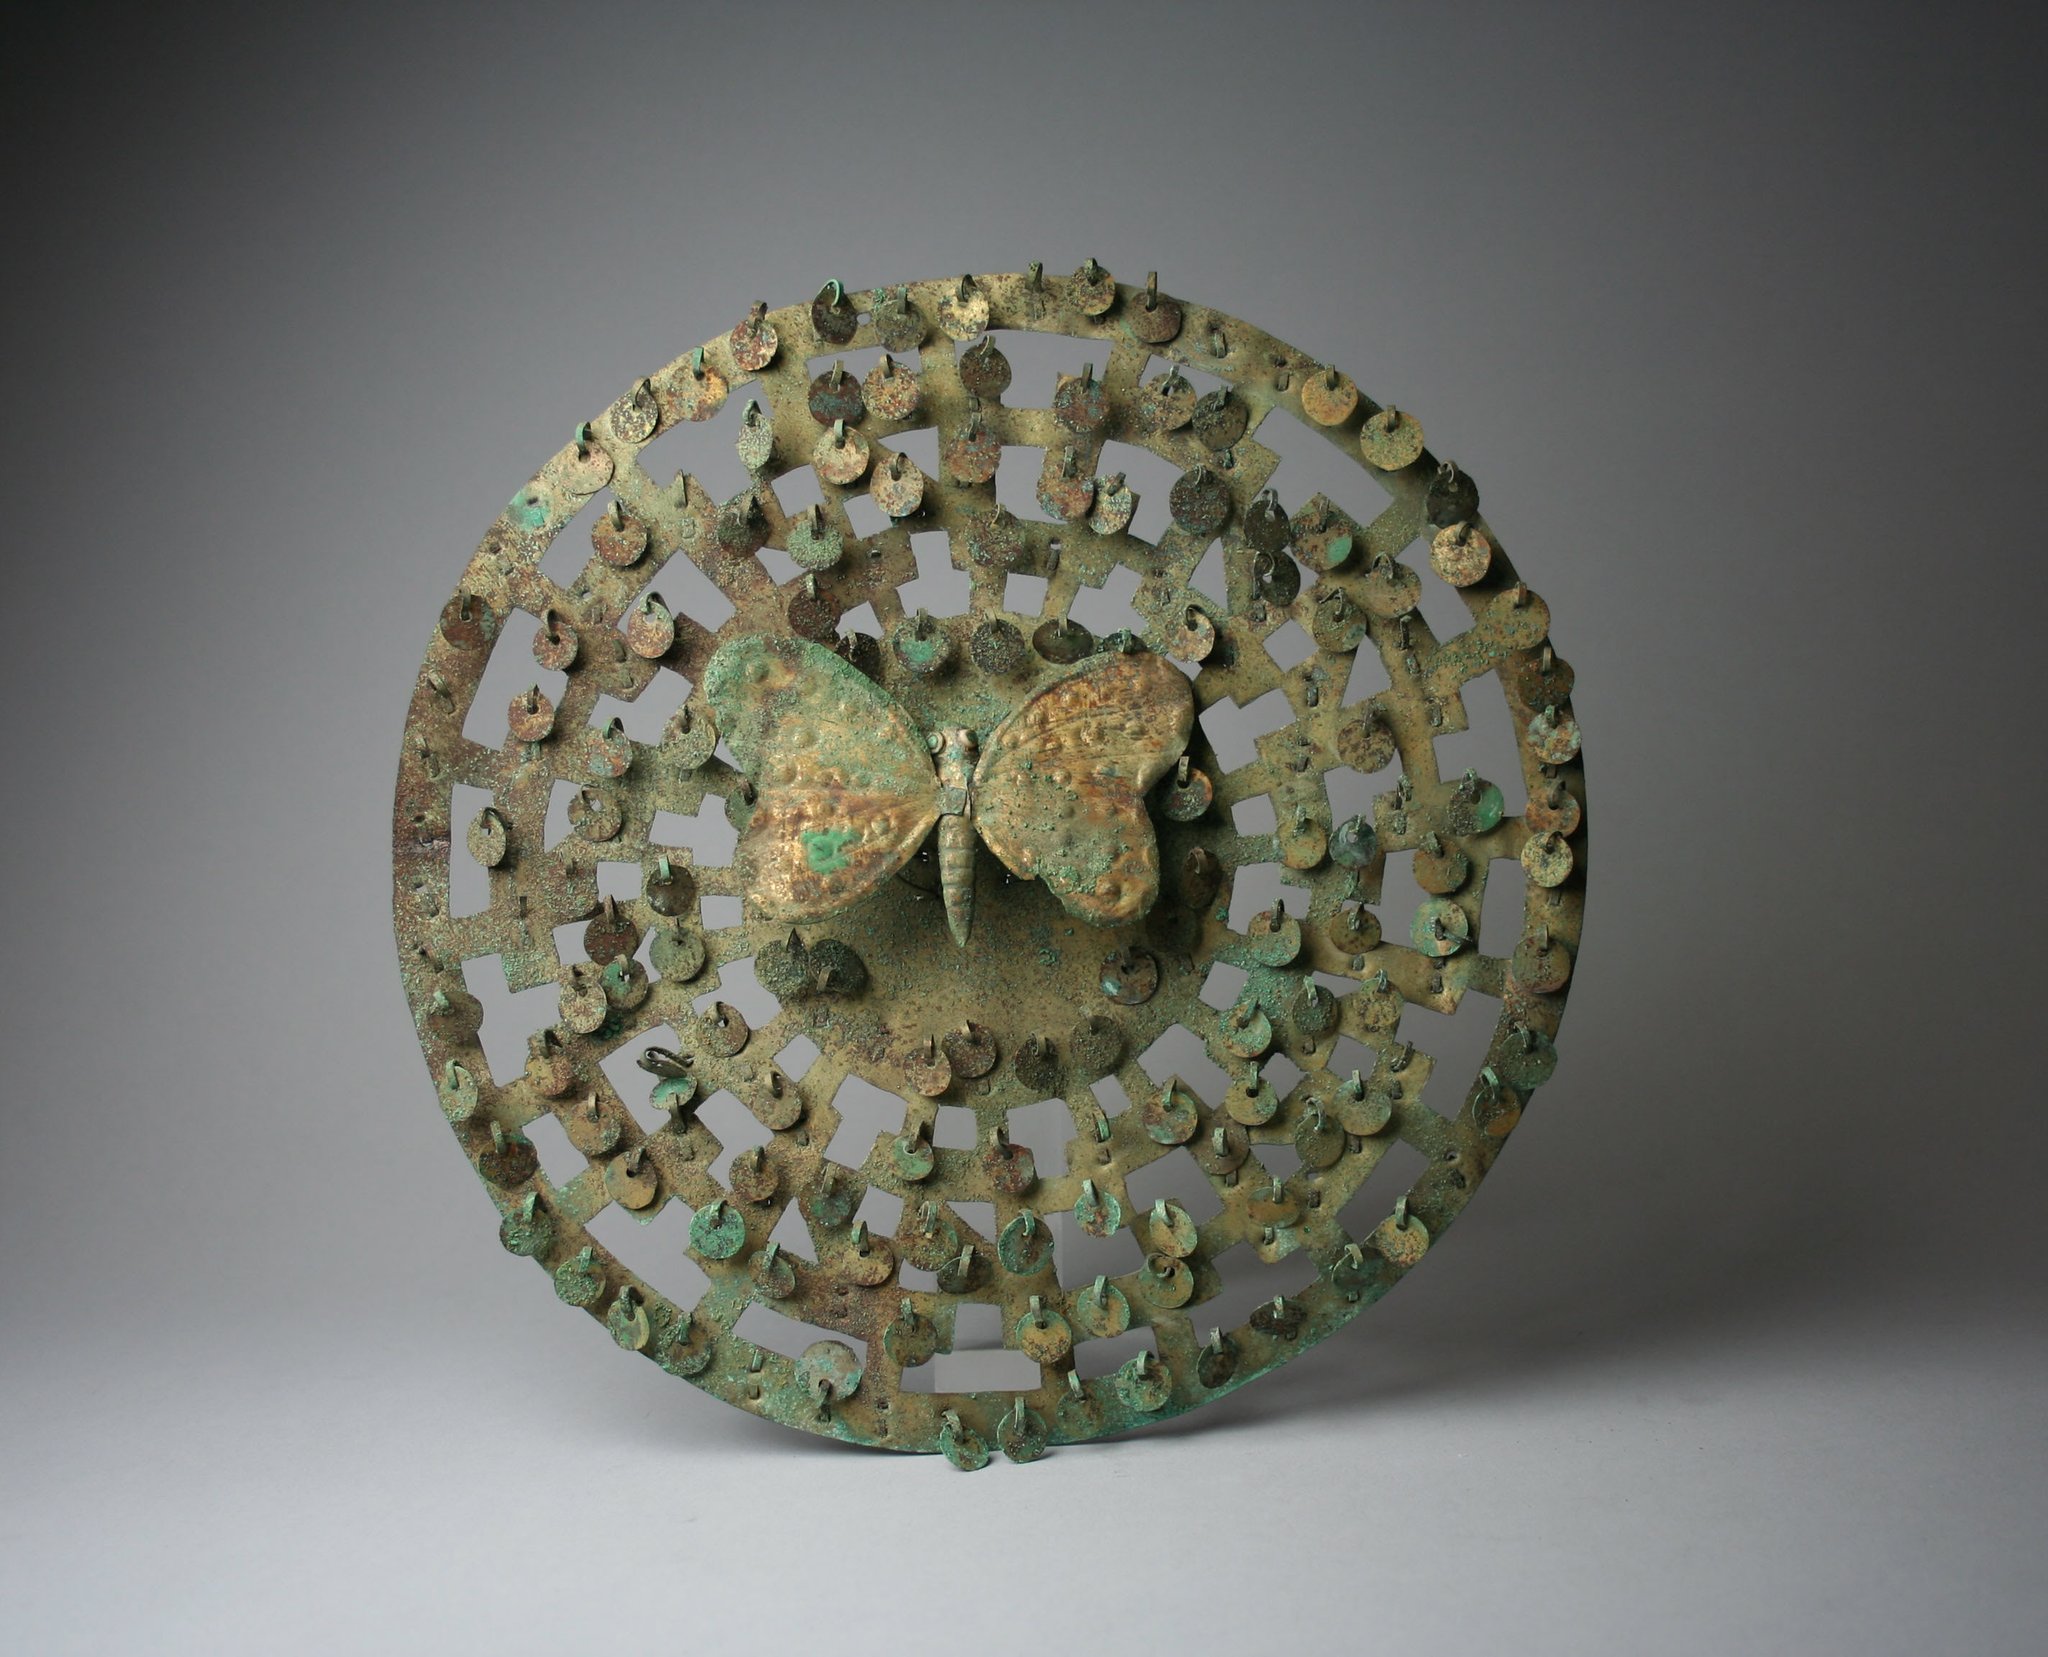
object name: ornament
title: Disk Ornament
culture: moche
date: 501-700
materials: gilt copper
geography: peru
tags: butterflies